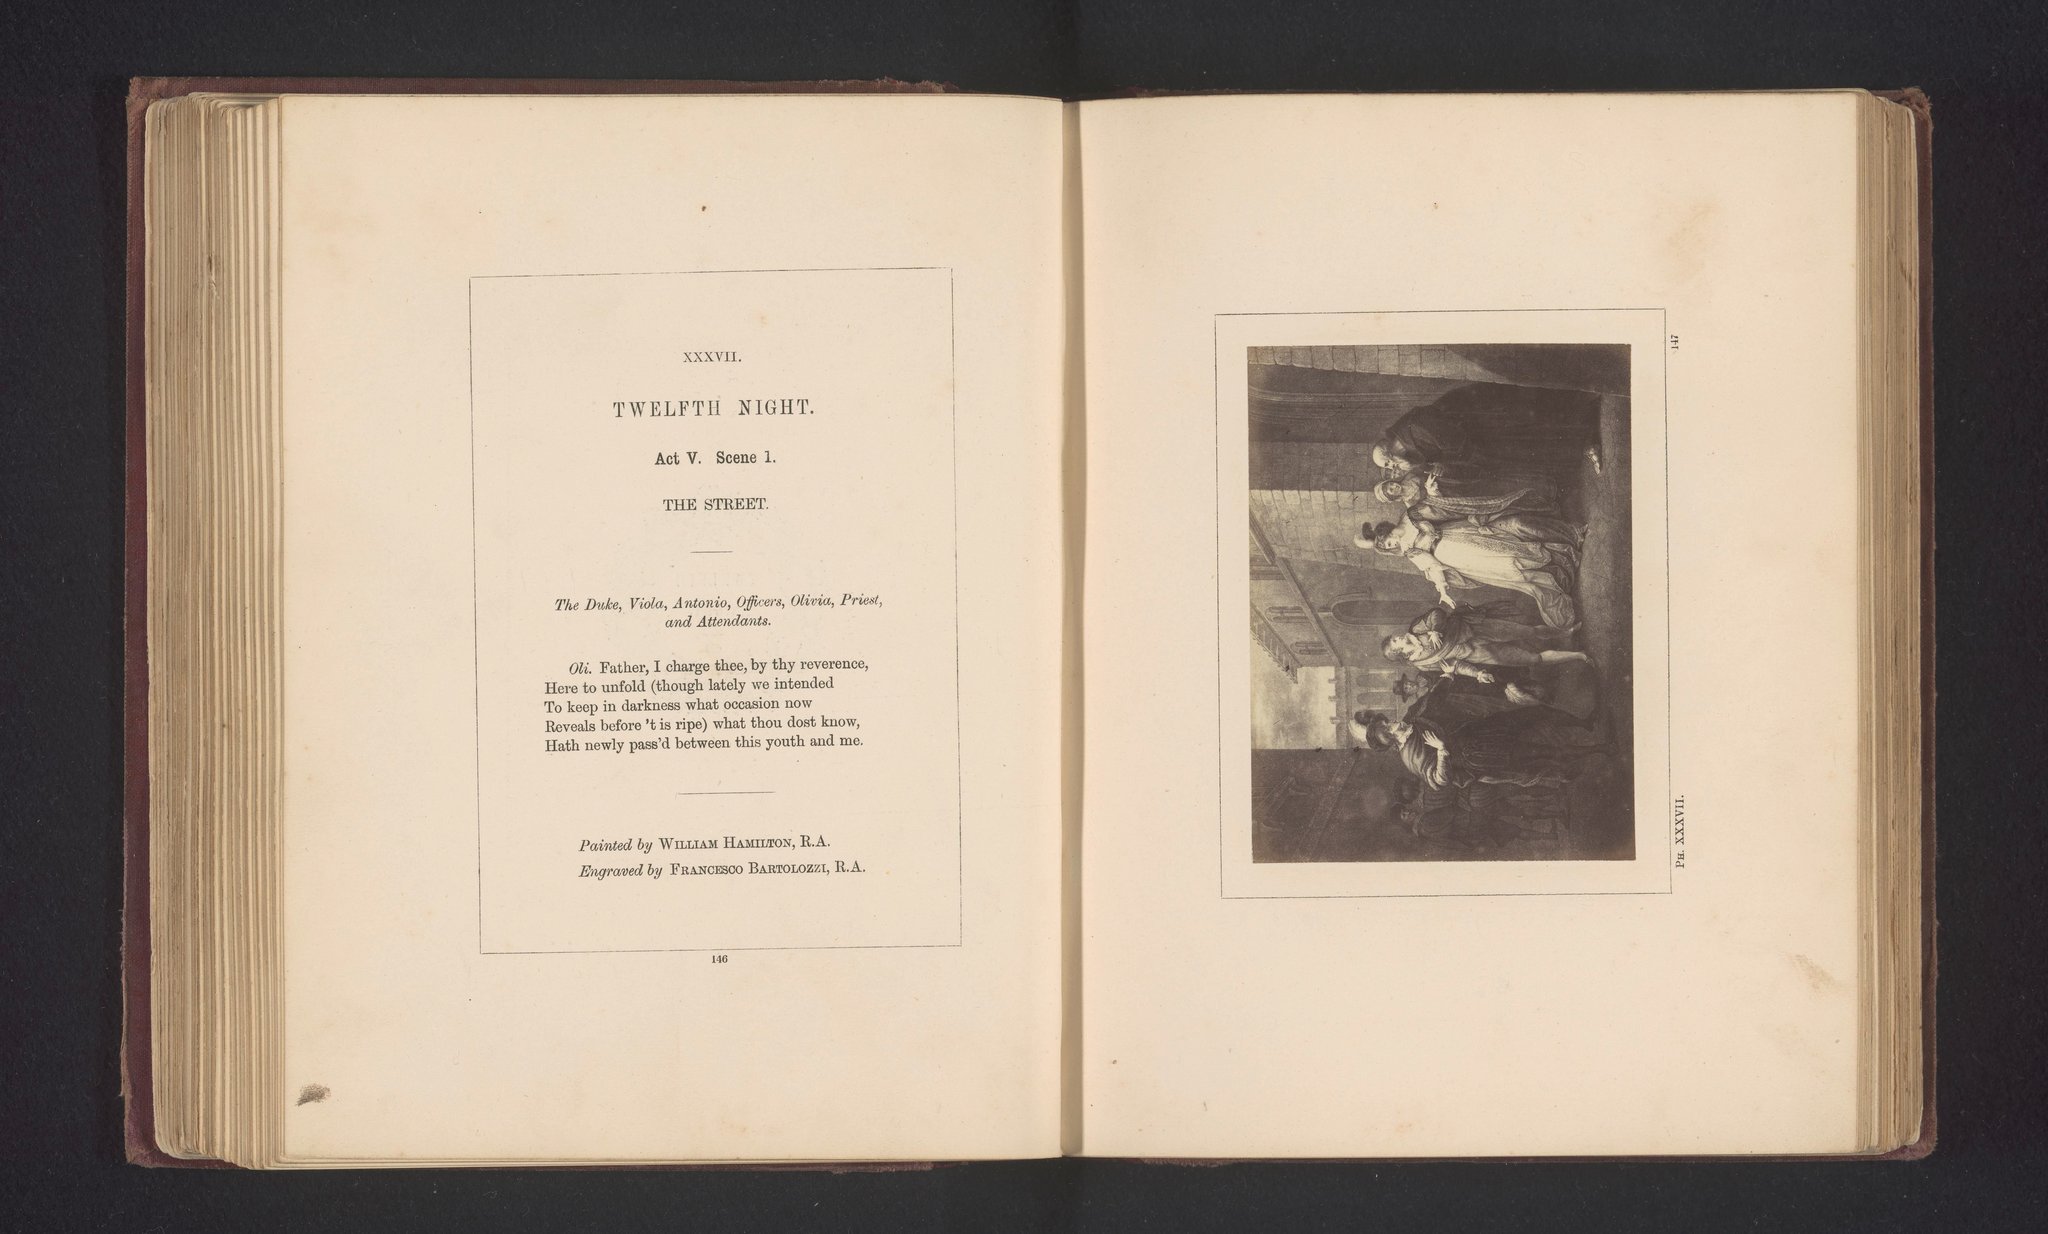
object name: page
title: Fotoreproductie van een prent naar een schilderij door William Hamilton, voorstellend een scene uit Driekoningenavond door William Shakespeare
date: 1854-1867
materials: photographic support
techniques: albumen print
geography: london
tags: specific works of literature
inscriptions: number: ‘Ph. XXXVII. 147’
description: Te zien is akte V, scene 1 met de hertog, Viola, Antonio en Olivia.